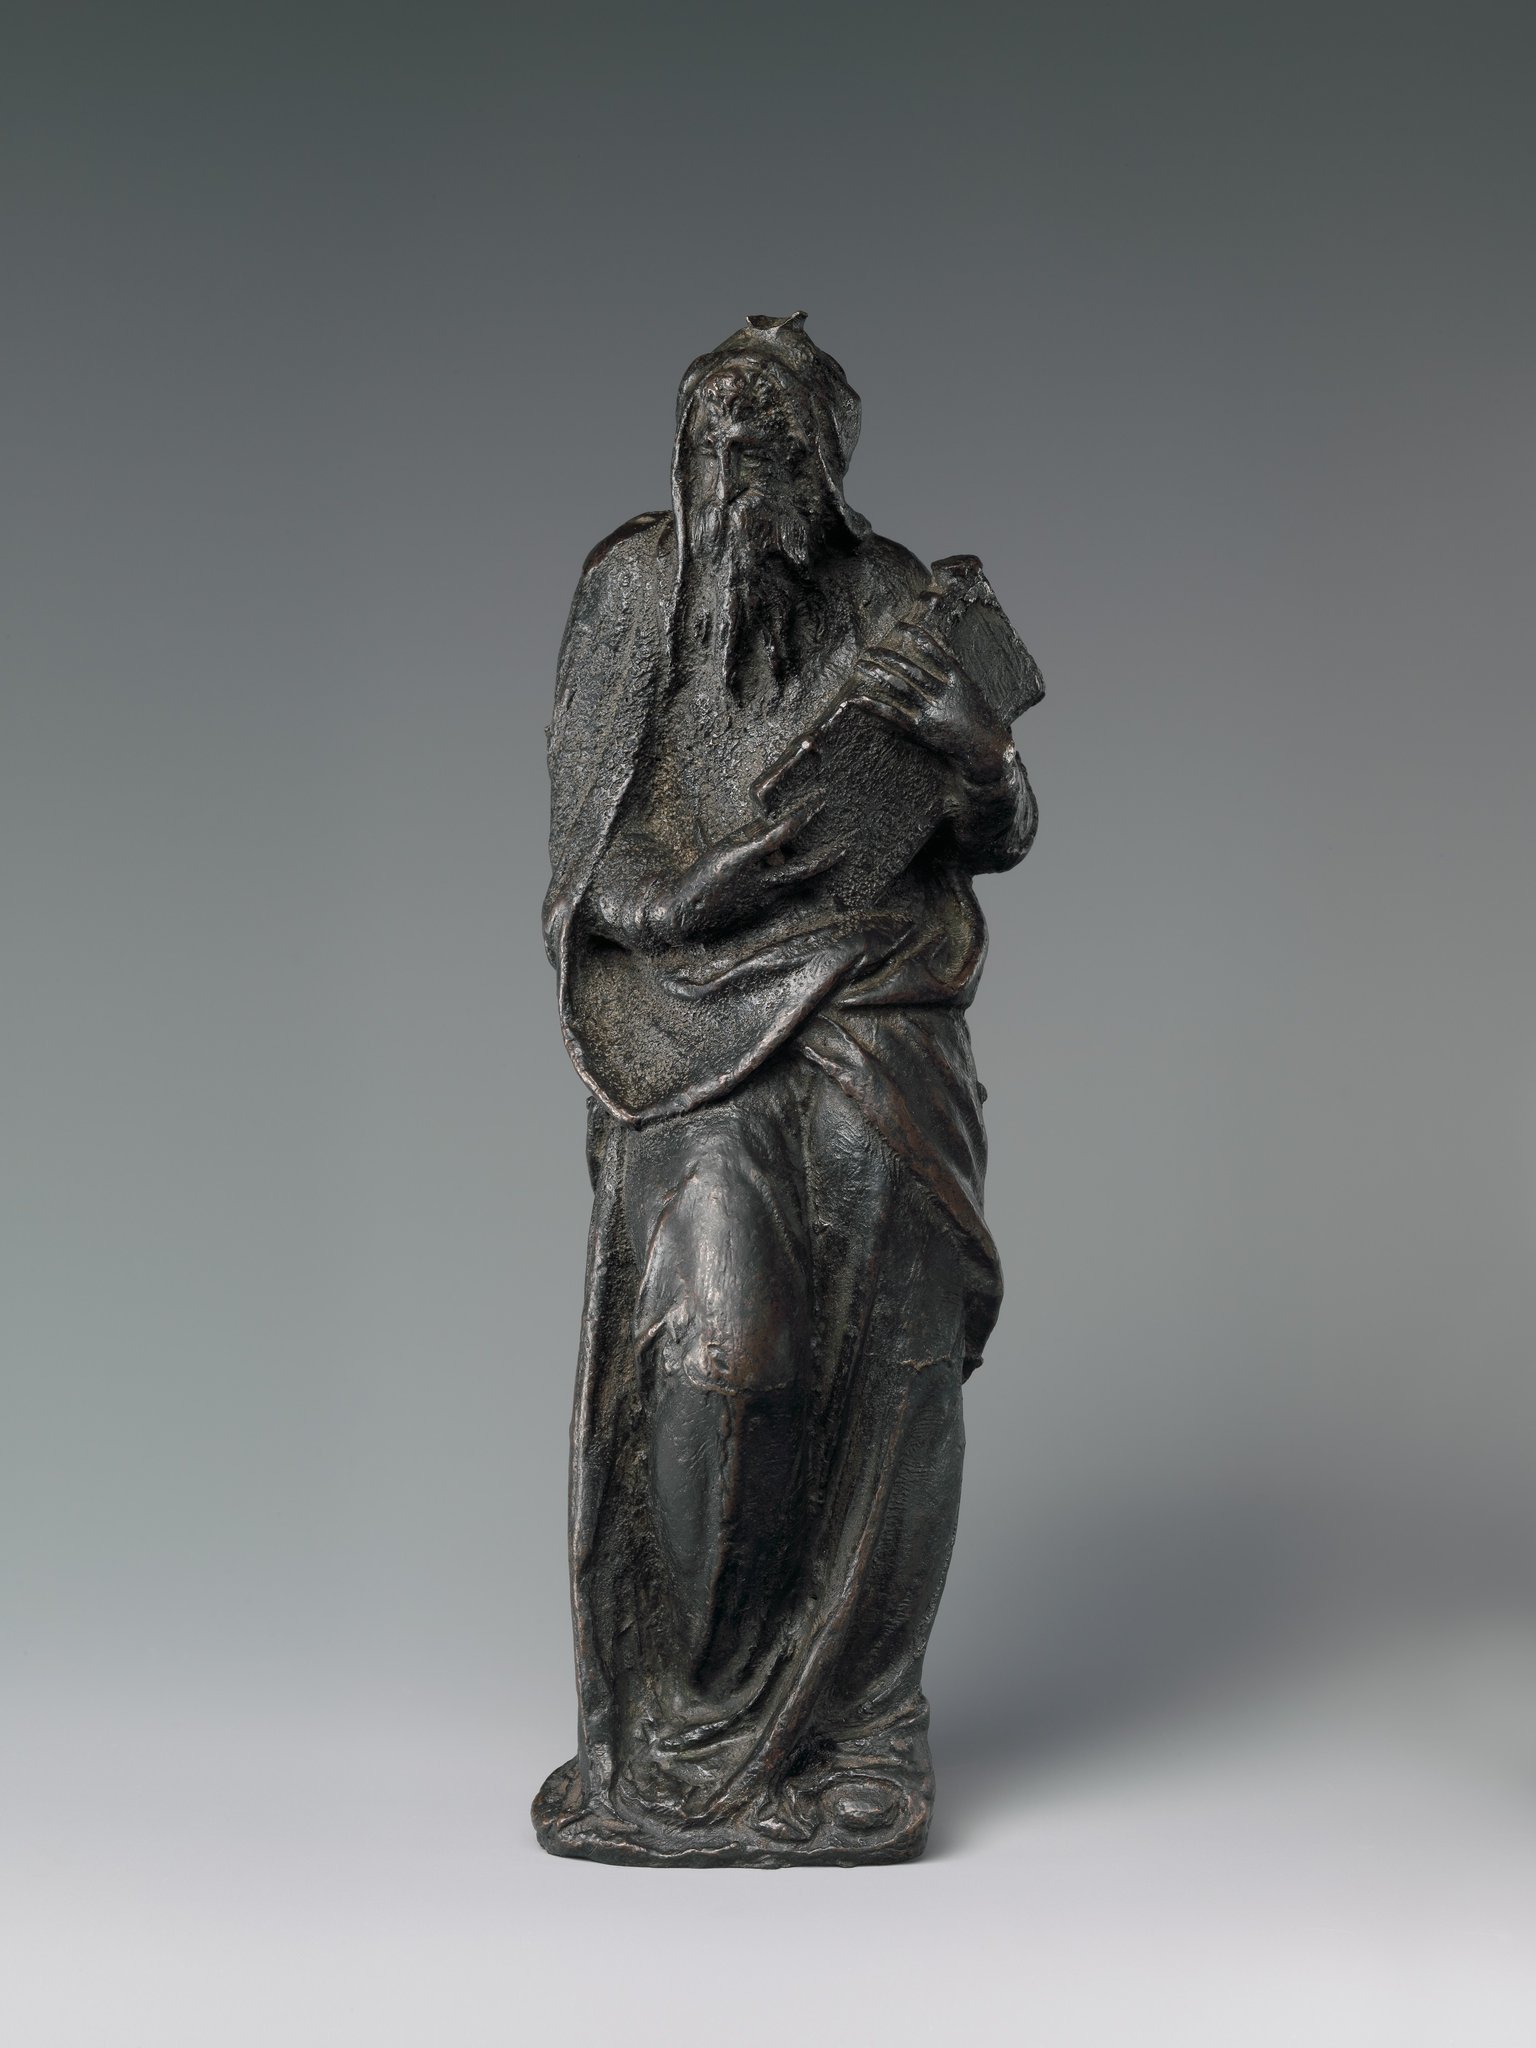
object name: statuette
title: A prophet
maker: tiziano minio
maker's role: artist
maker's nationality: italian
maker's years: 1517-1552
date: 1534-1566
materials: bronze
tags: men